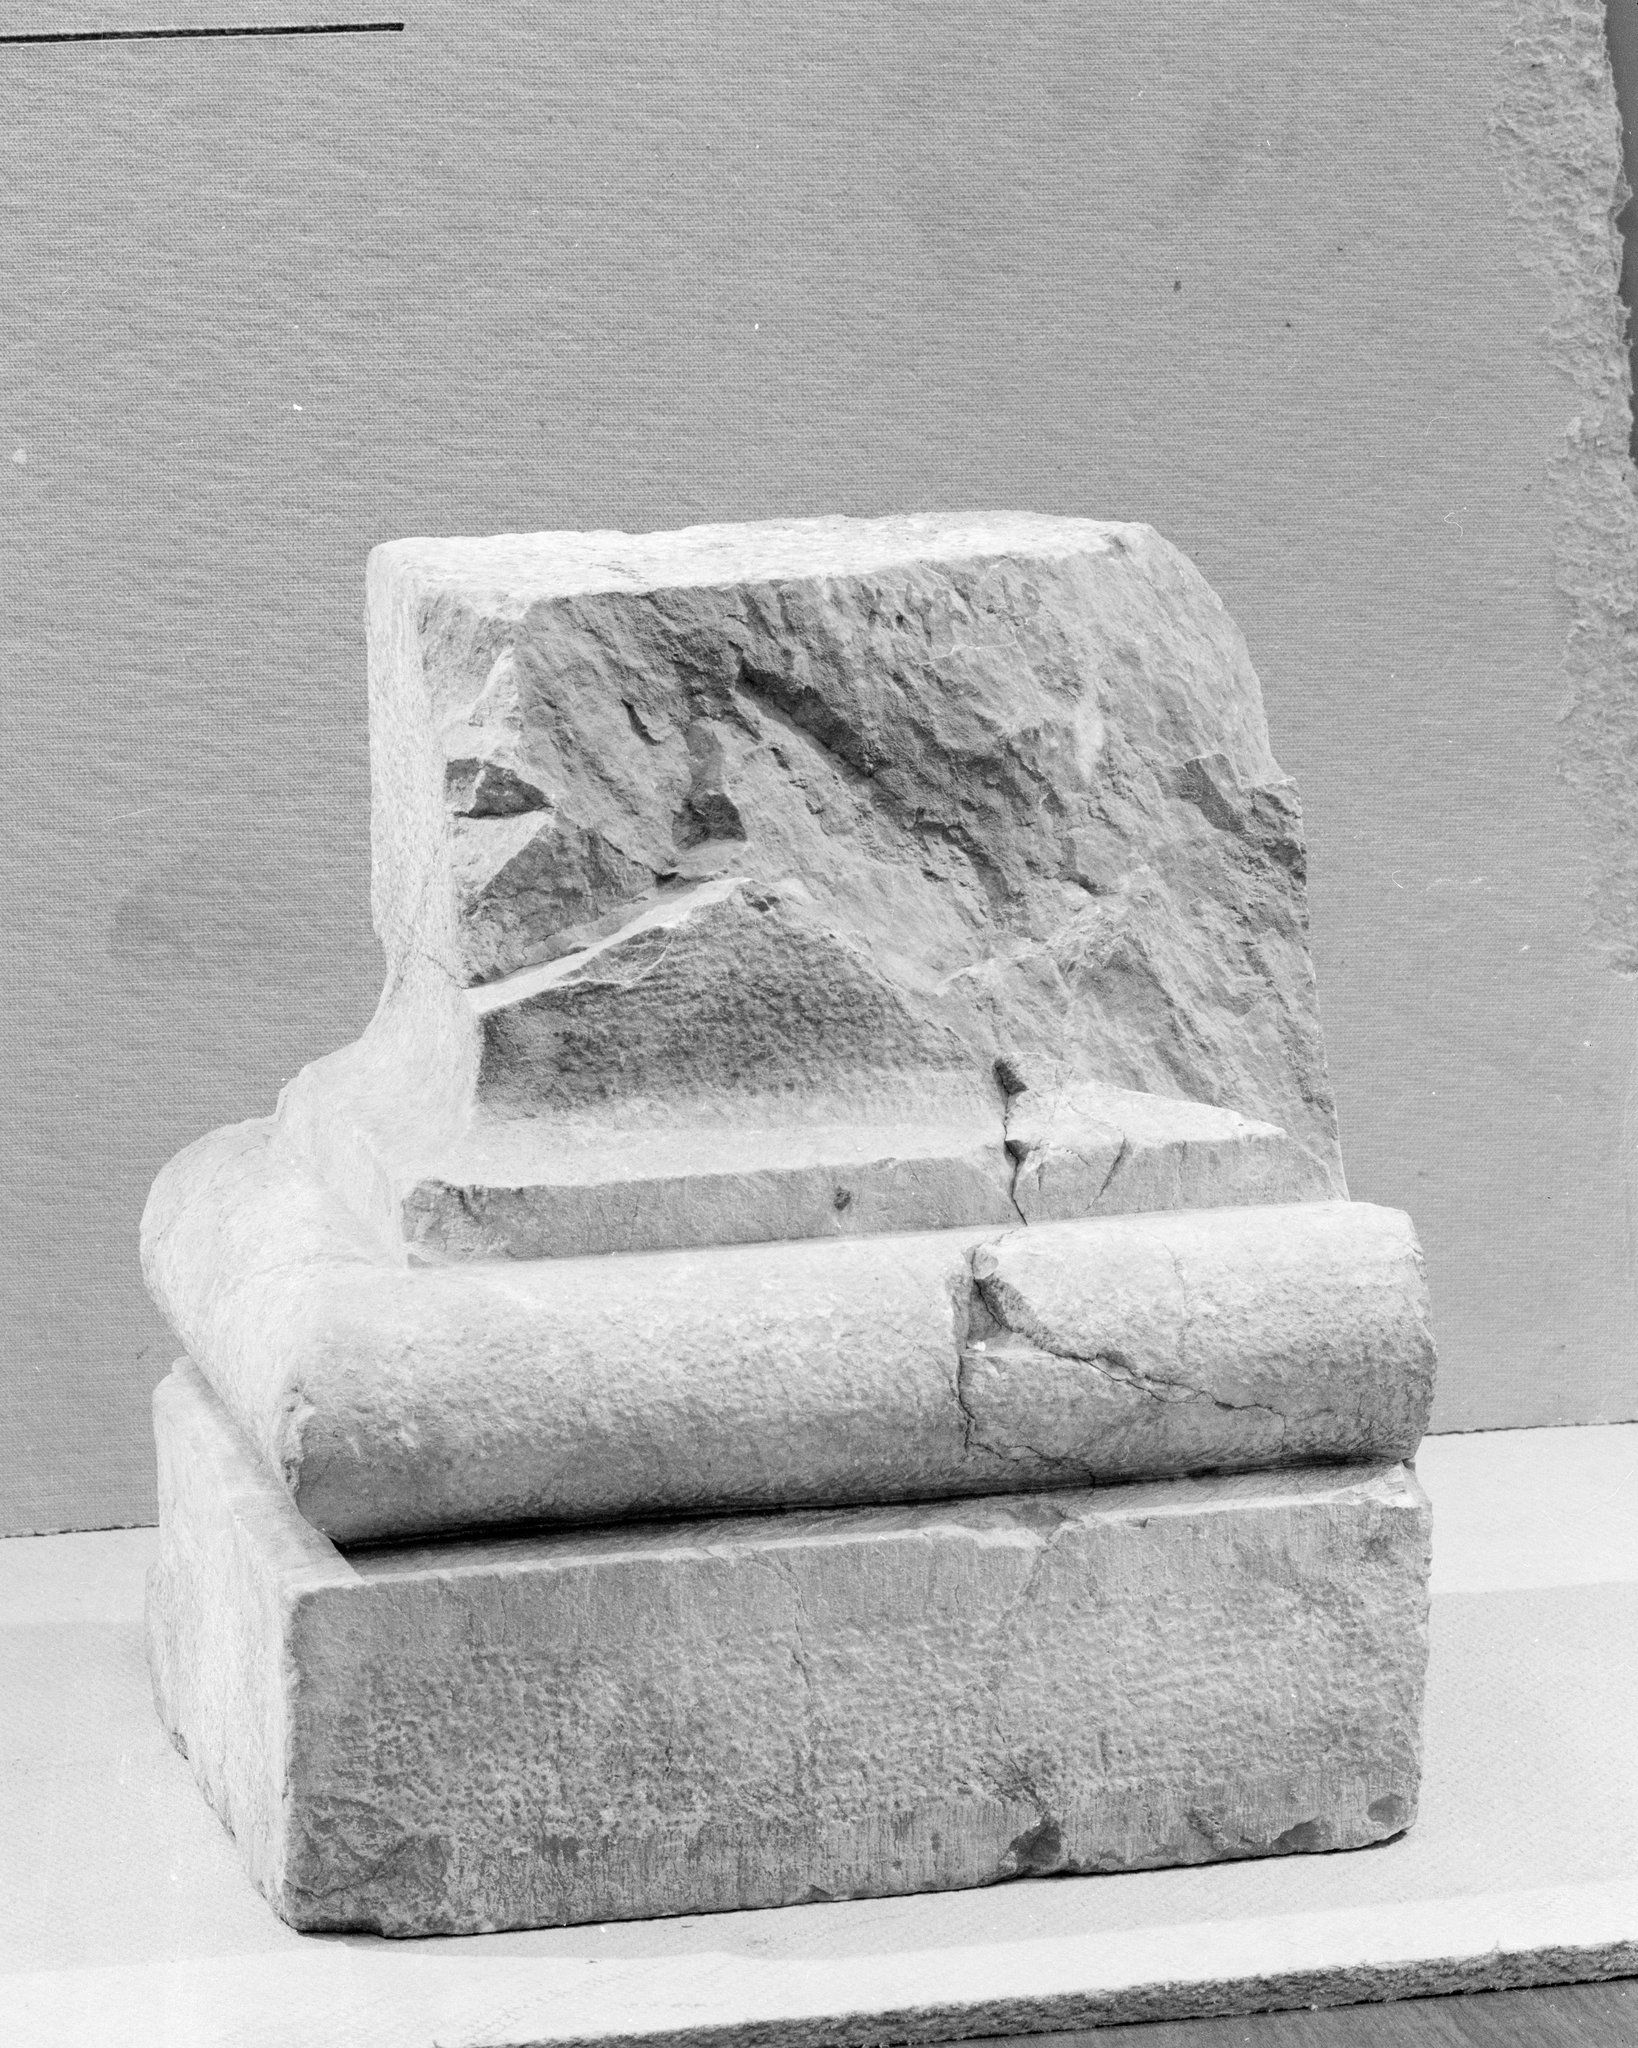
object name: base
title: Pier Base Section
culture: french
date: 1130-1140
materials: stone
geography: france